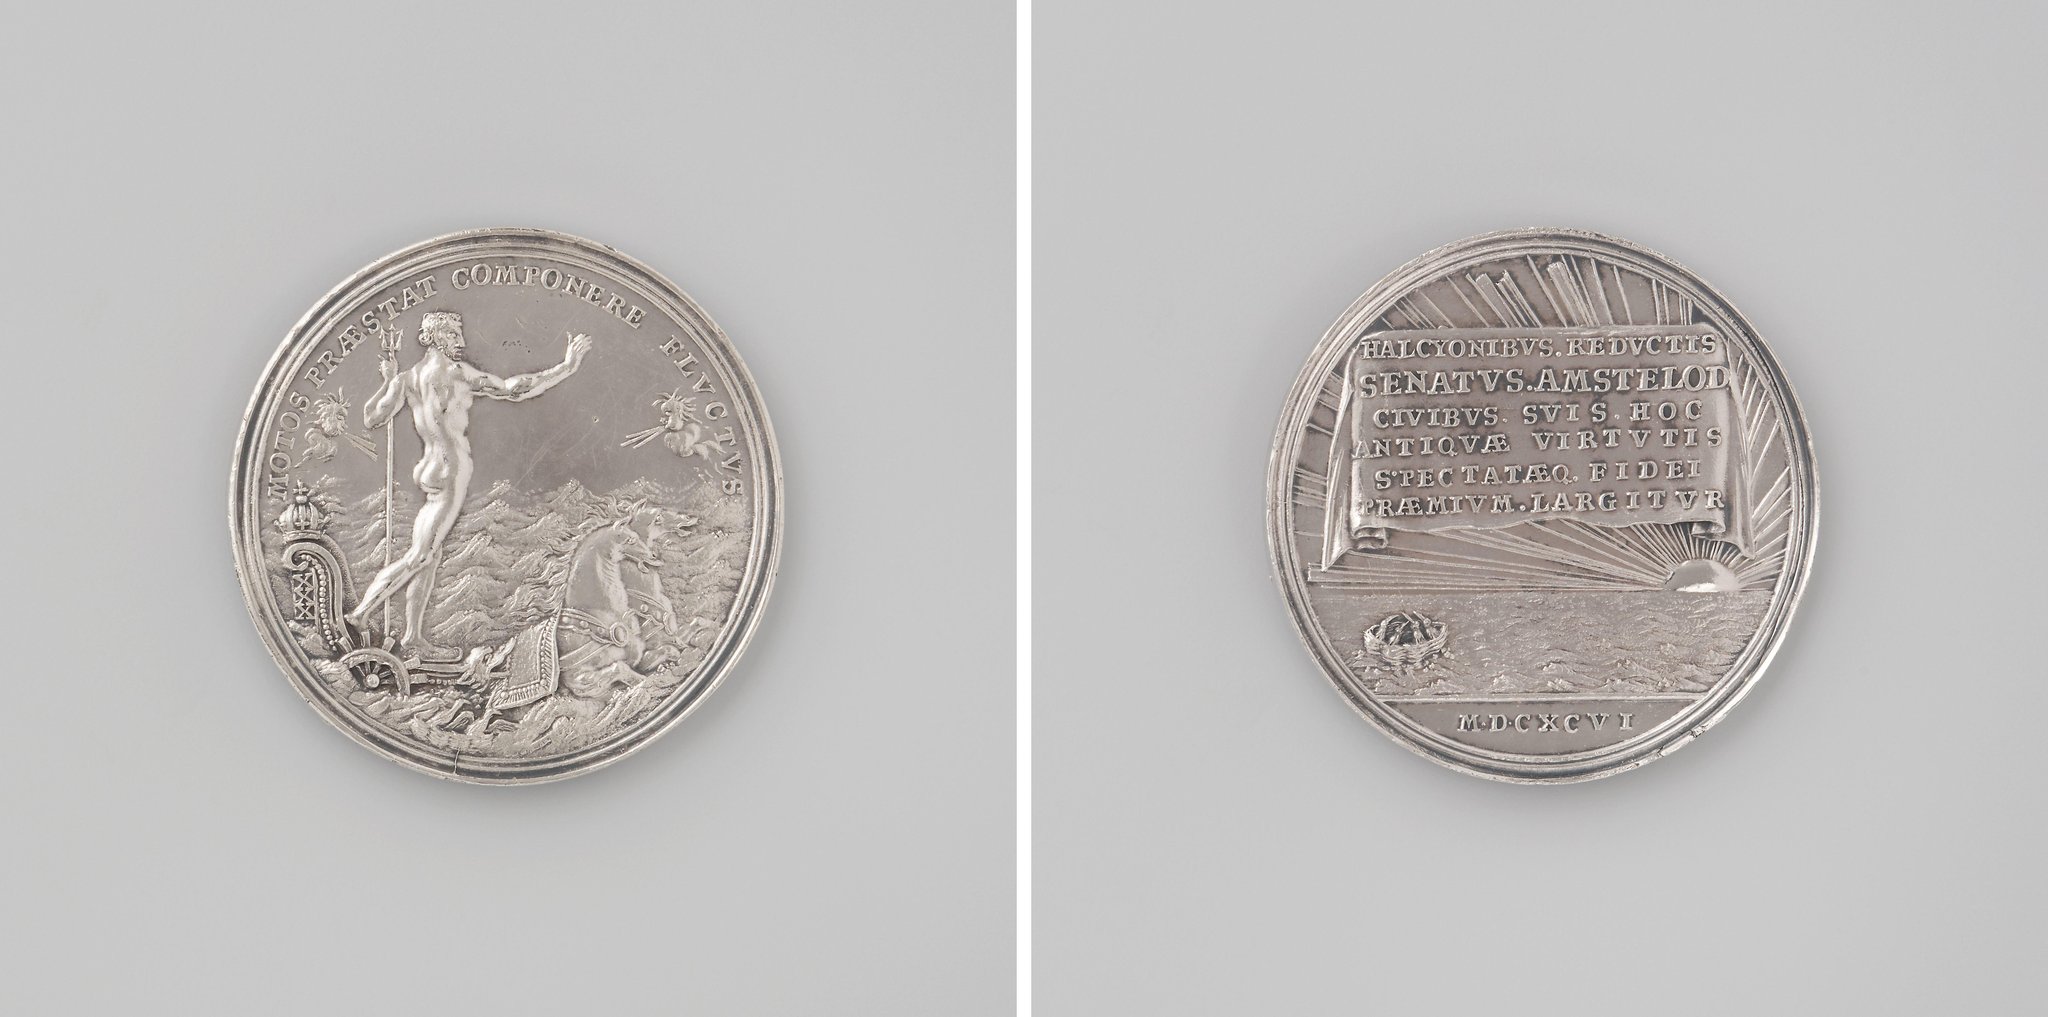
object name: history medal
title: Stillen van het aansprekersoproer te Amsterdam, penning aan de gewapende burgers vereerd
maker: Anonymous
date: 1696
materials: silver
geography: netherlands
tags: amsterdam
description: Zilveren penning. Voorzijde: Neptunus met drietand staande op zijn wagen in een woelige zee straft vertoornd de losgelaten stormwinden, op voorgrond twee vogels die uit nest dreigen te vallen binnen omschrift. Keerzijde: vier vogels in nest op kalme zee, terwijl zon opkomt onder wimpel met opschrift; afsnede: jaartal.